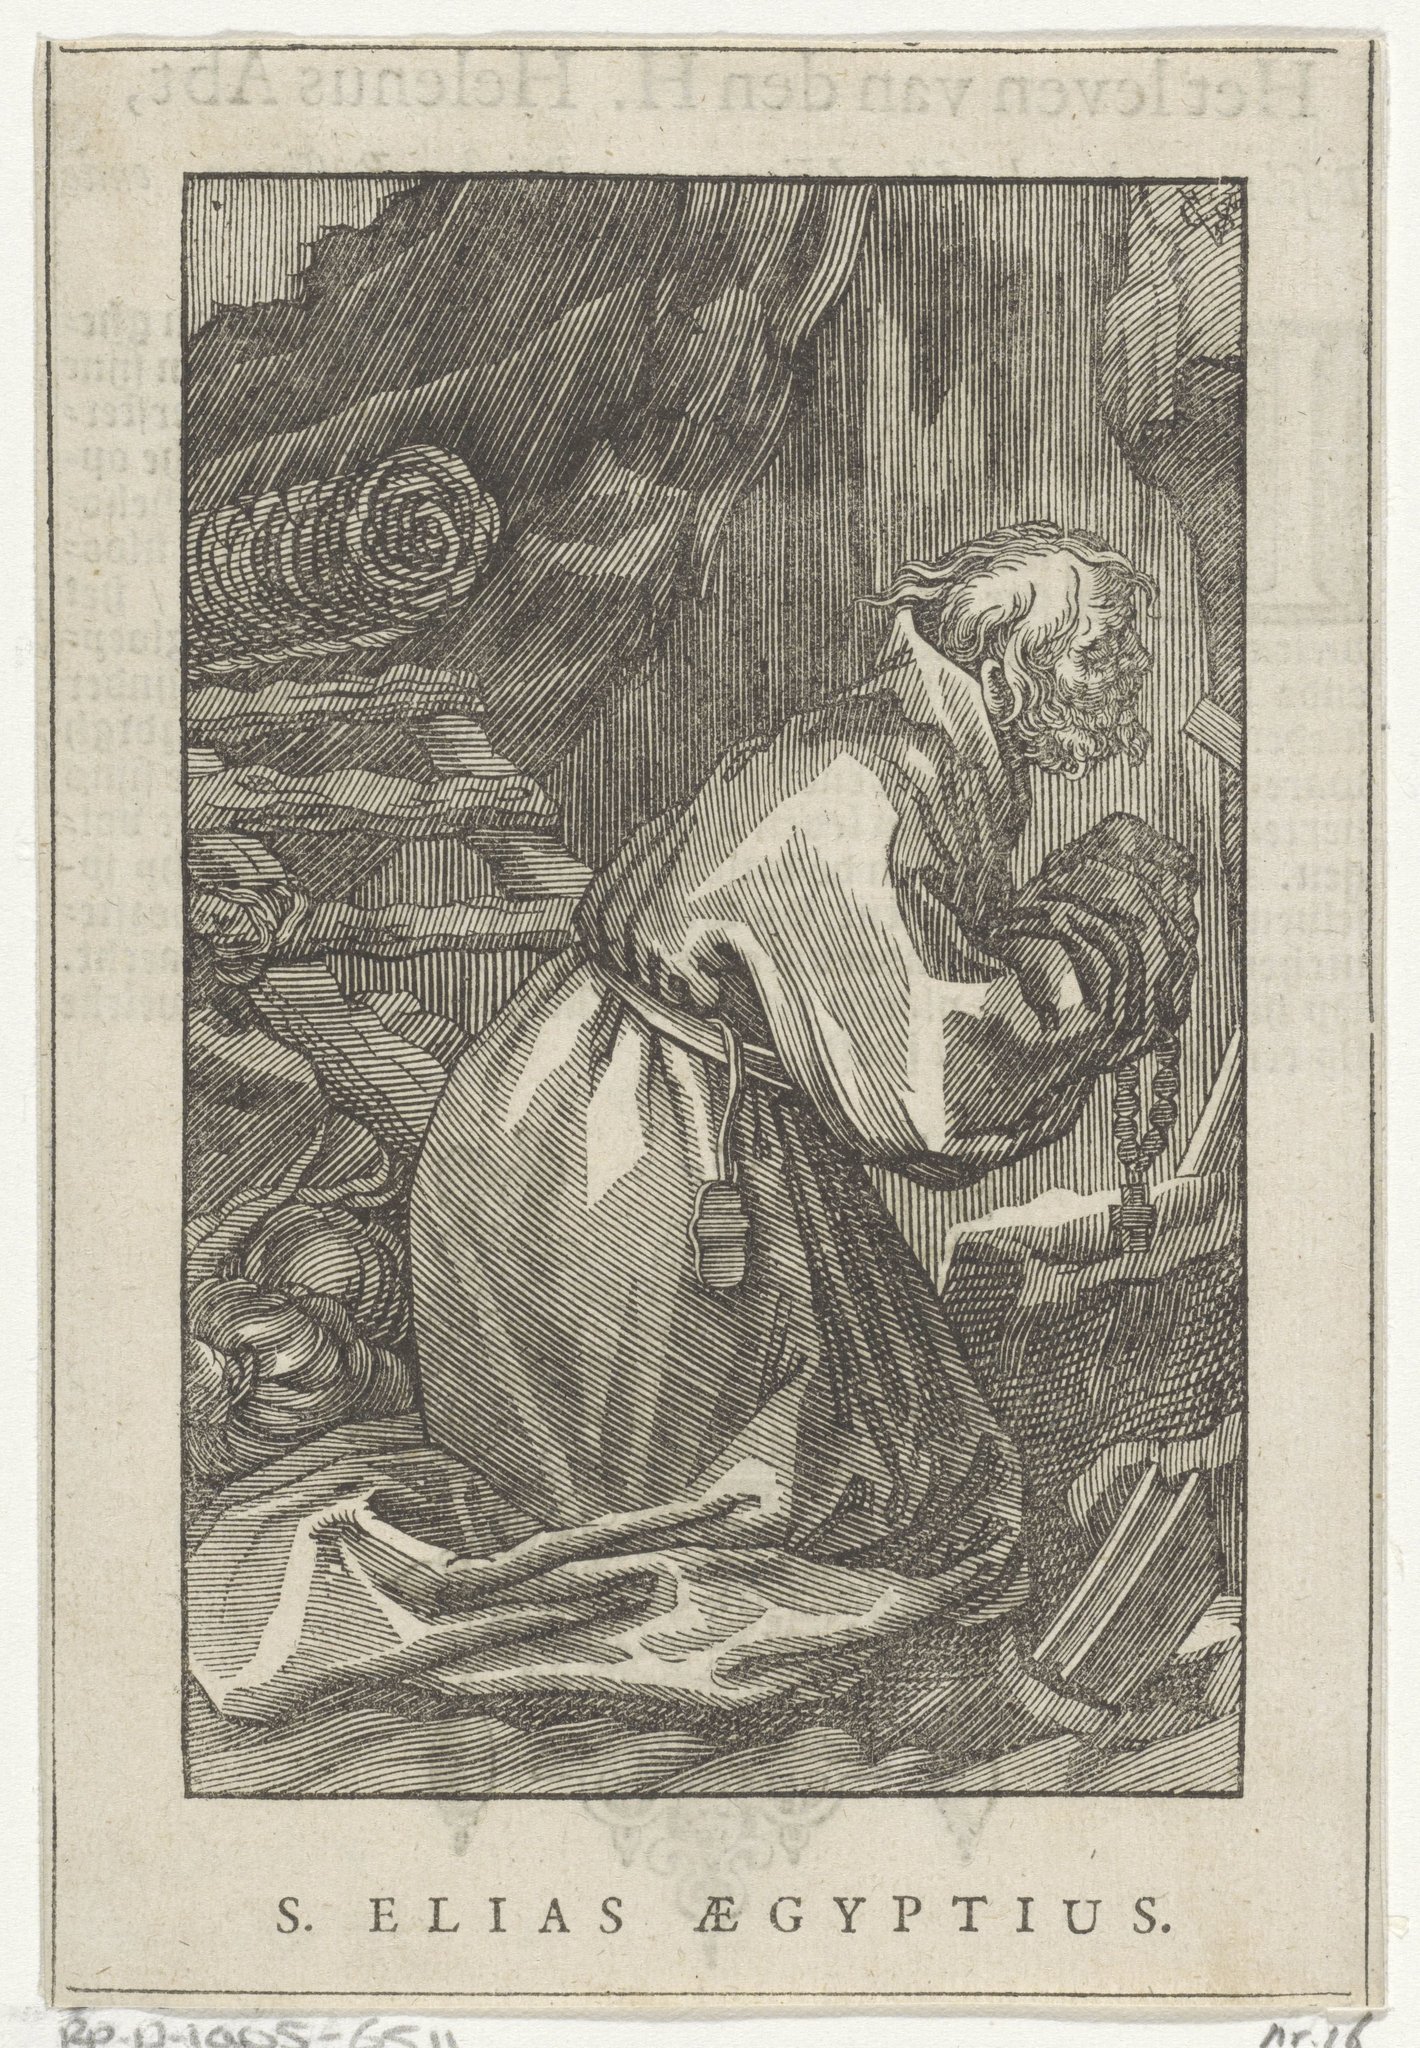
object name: print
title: S. Elias Aegyptius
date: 1644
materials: paper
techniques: letterpress printing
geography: amsterdam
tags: saints, anchorite, hermit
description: Prent uit: Rosweyde, Heribert. 'tBosch der eremyten ende eremitinnen, van Aegypten ende Palestinen. Amsterdam: Pieter Jacobsz. Paets, 1644.